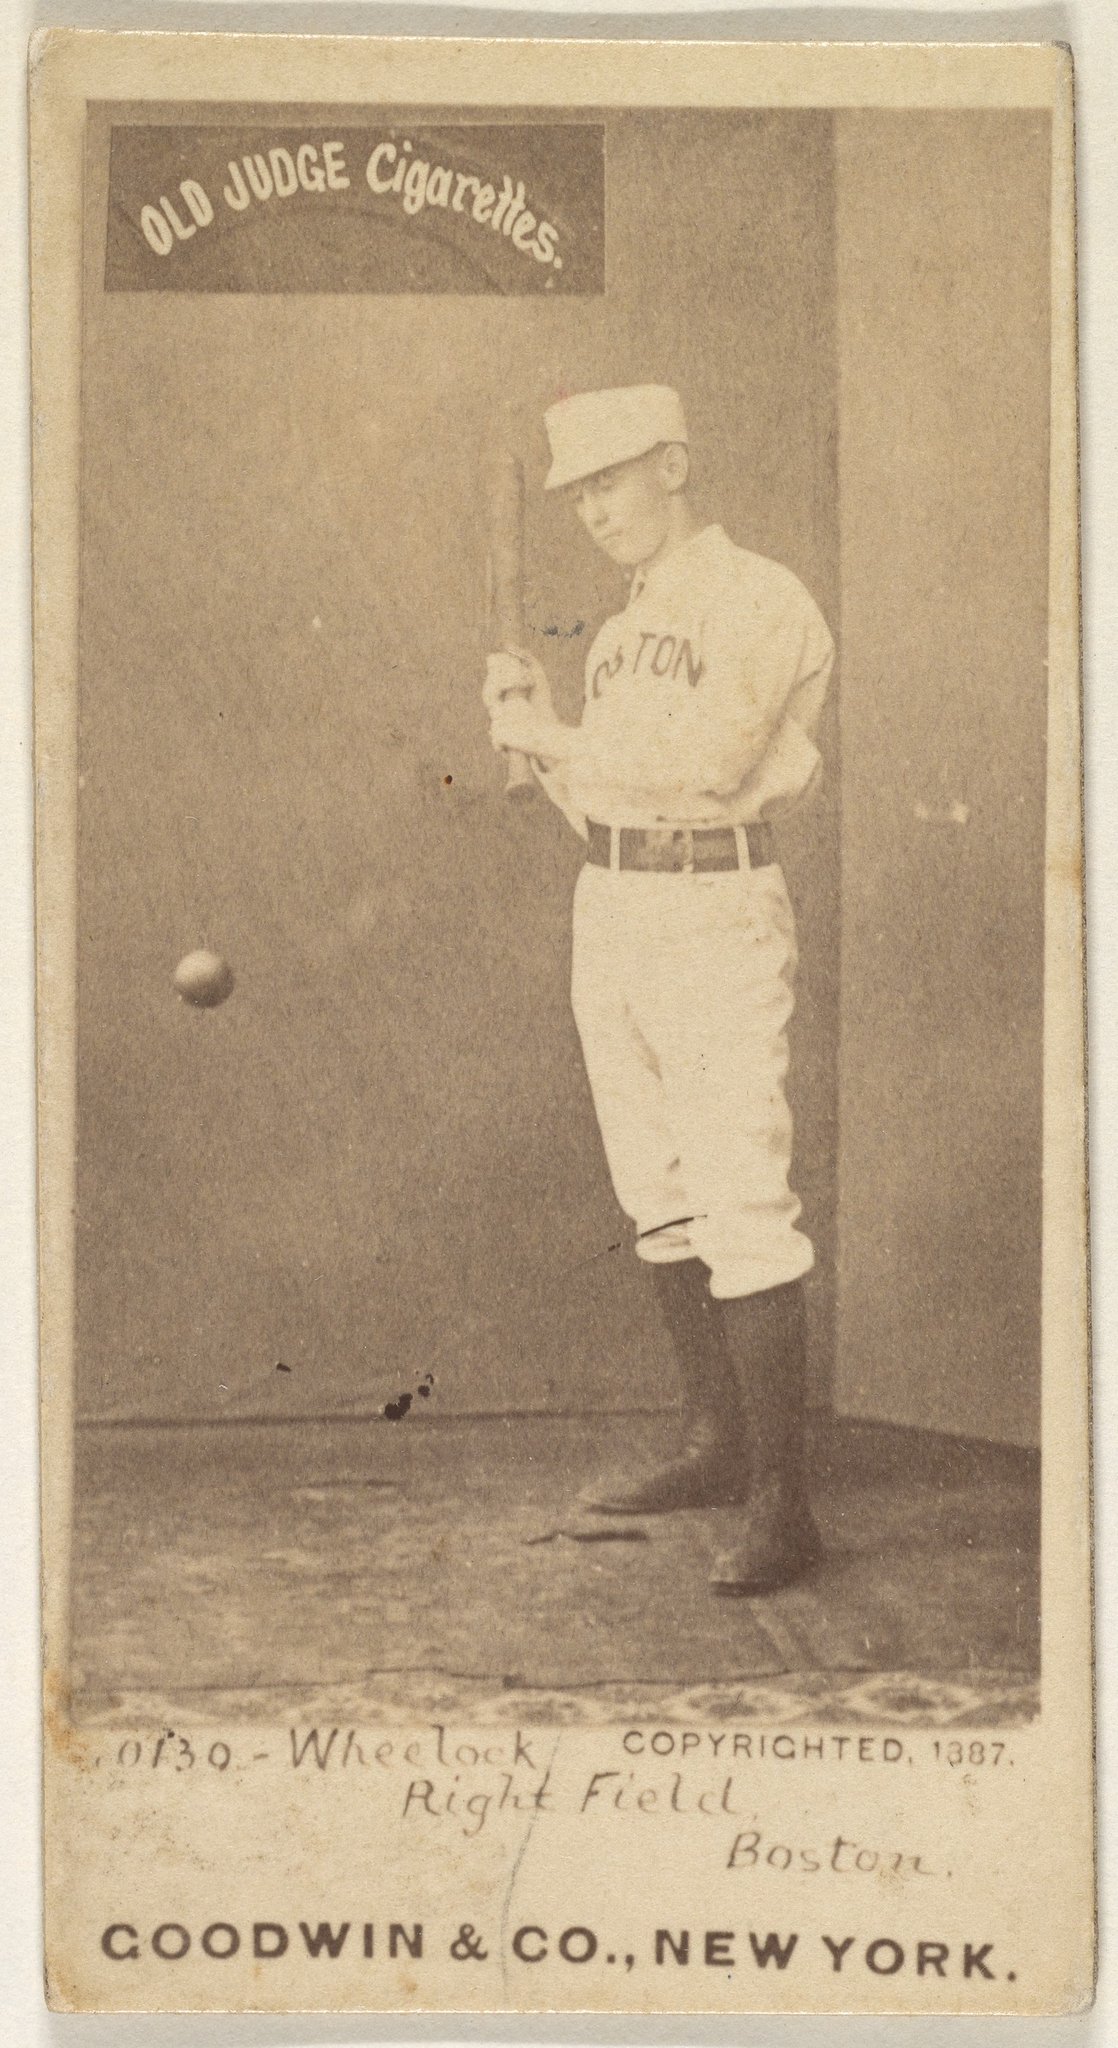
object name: baseball card, photograph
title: Wheelock, Right Field, Boston, from the Old Judge series (N172) for Old Judge Cigarettes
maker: goodwin & company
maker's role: publisher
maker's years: 1850-1950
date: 1887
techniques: albumen silver print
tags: men,portraits,baseball,athletes